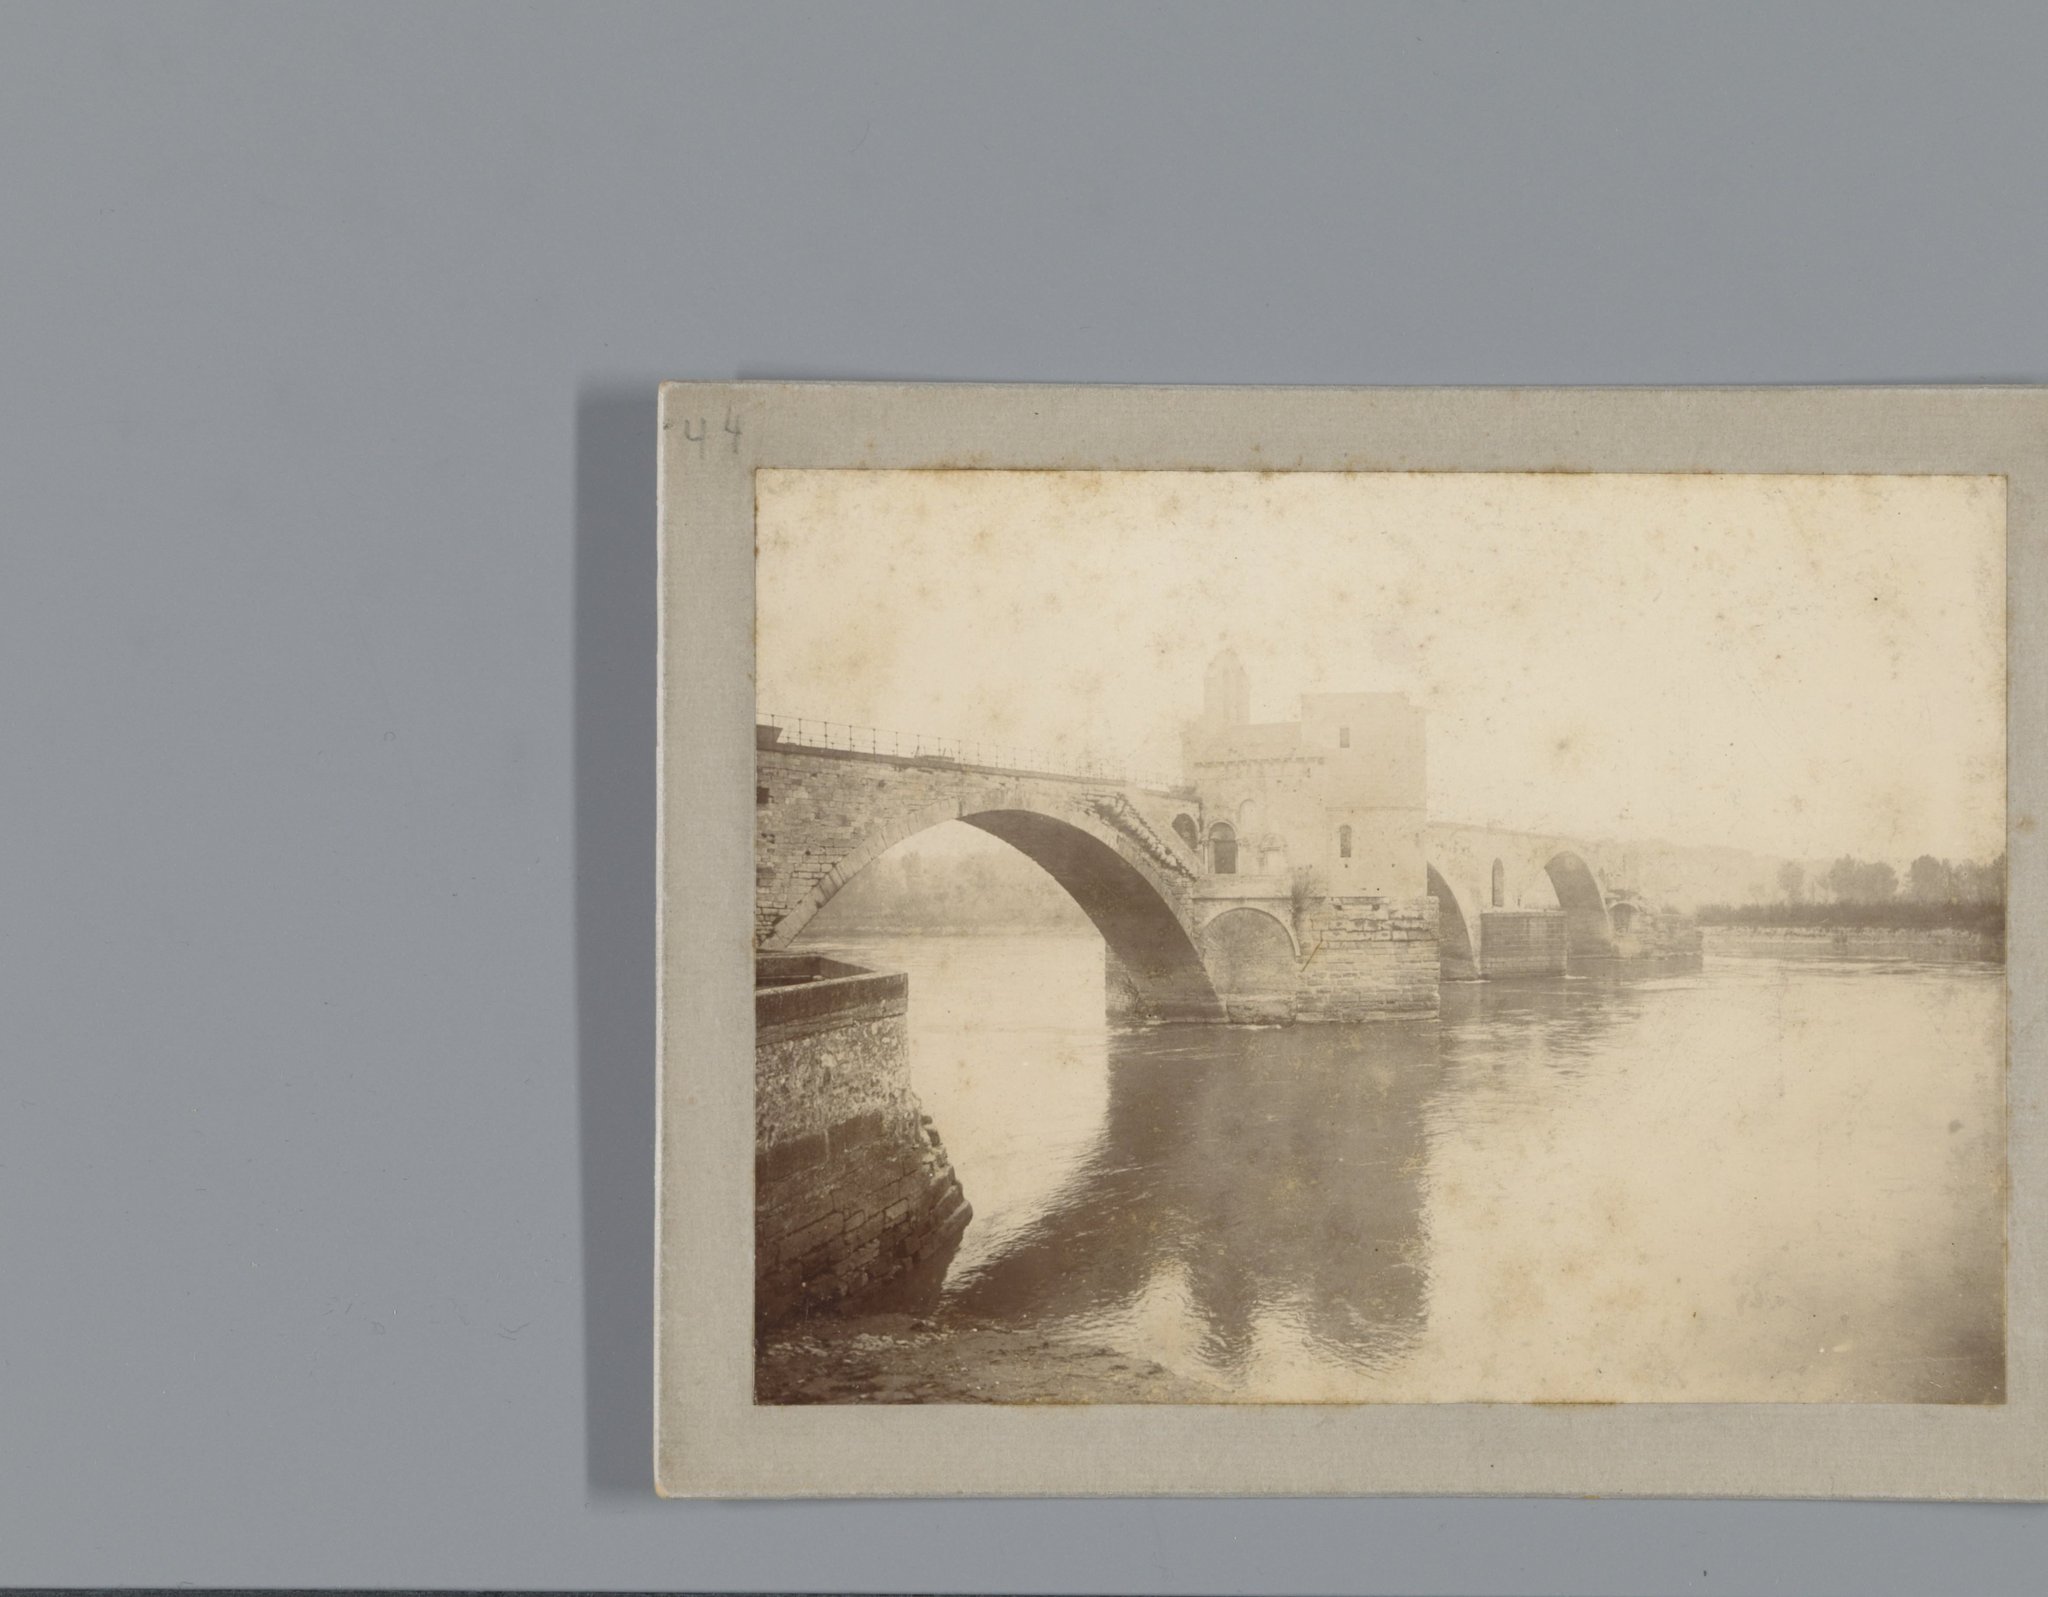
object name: photograph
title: Pont Saint-Bénezet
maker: willem witsen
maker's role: draughtsman, painter, print maker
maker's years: 1860-1923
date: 1860-1915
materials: cardboard, paper, photographic support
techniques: gelatin silver print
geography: avignon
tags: pont saint-bénezet